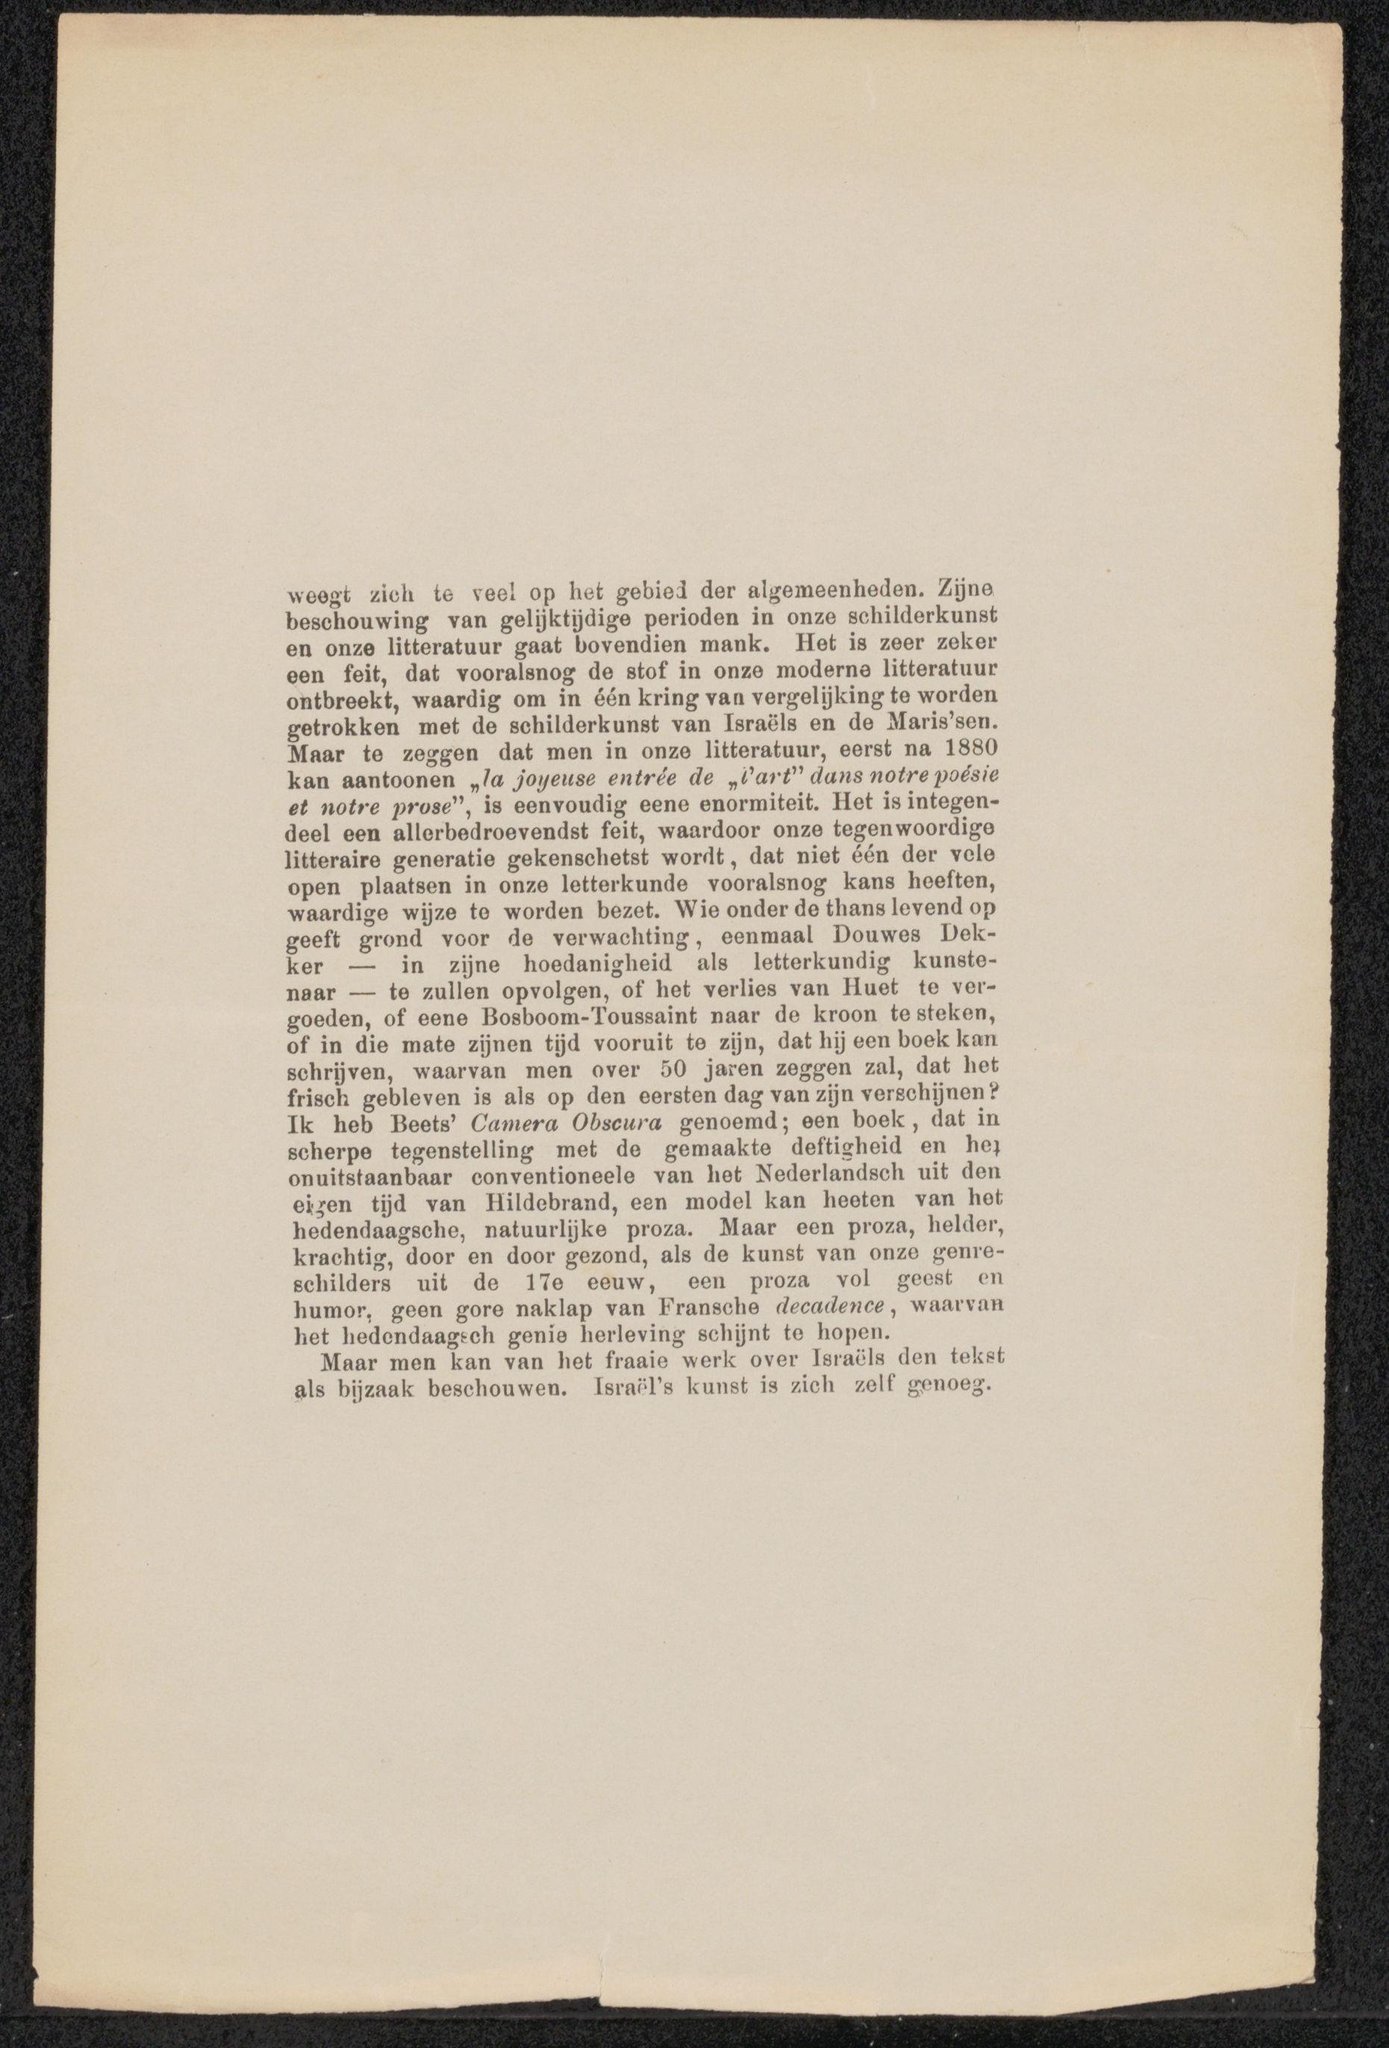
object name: article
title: Artikel over Jozef Israëls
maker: Anonymous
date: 1890-1891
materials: paper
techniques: printing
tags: painter, print maker, draughtsman, jozef israëls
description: Vormt doorlopende tekst met RP-D-J.ISRAELS-DOC.13A EN RP-D-J.ISRAËLS-DOC.13B.